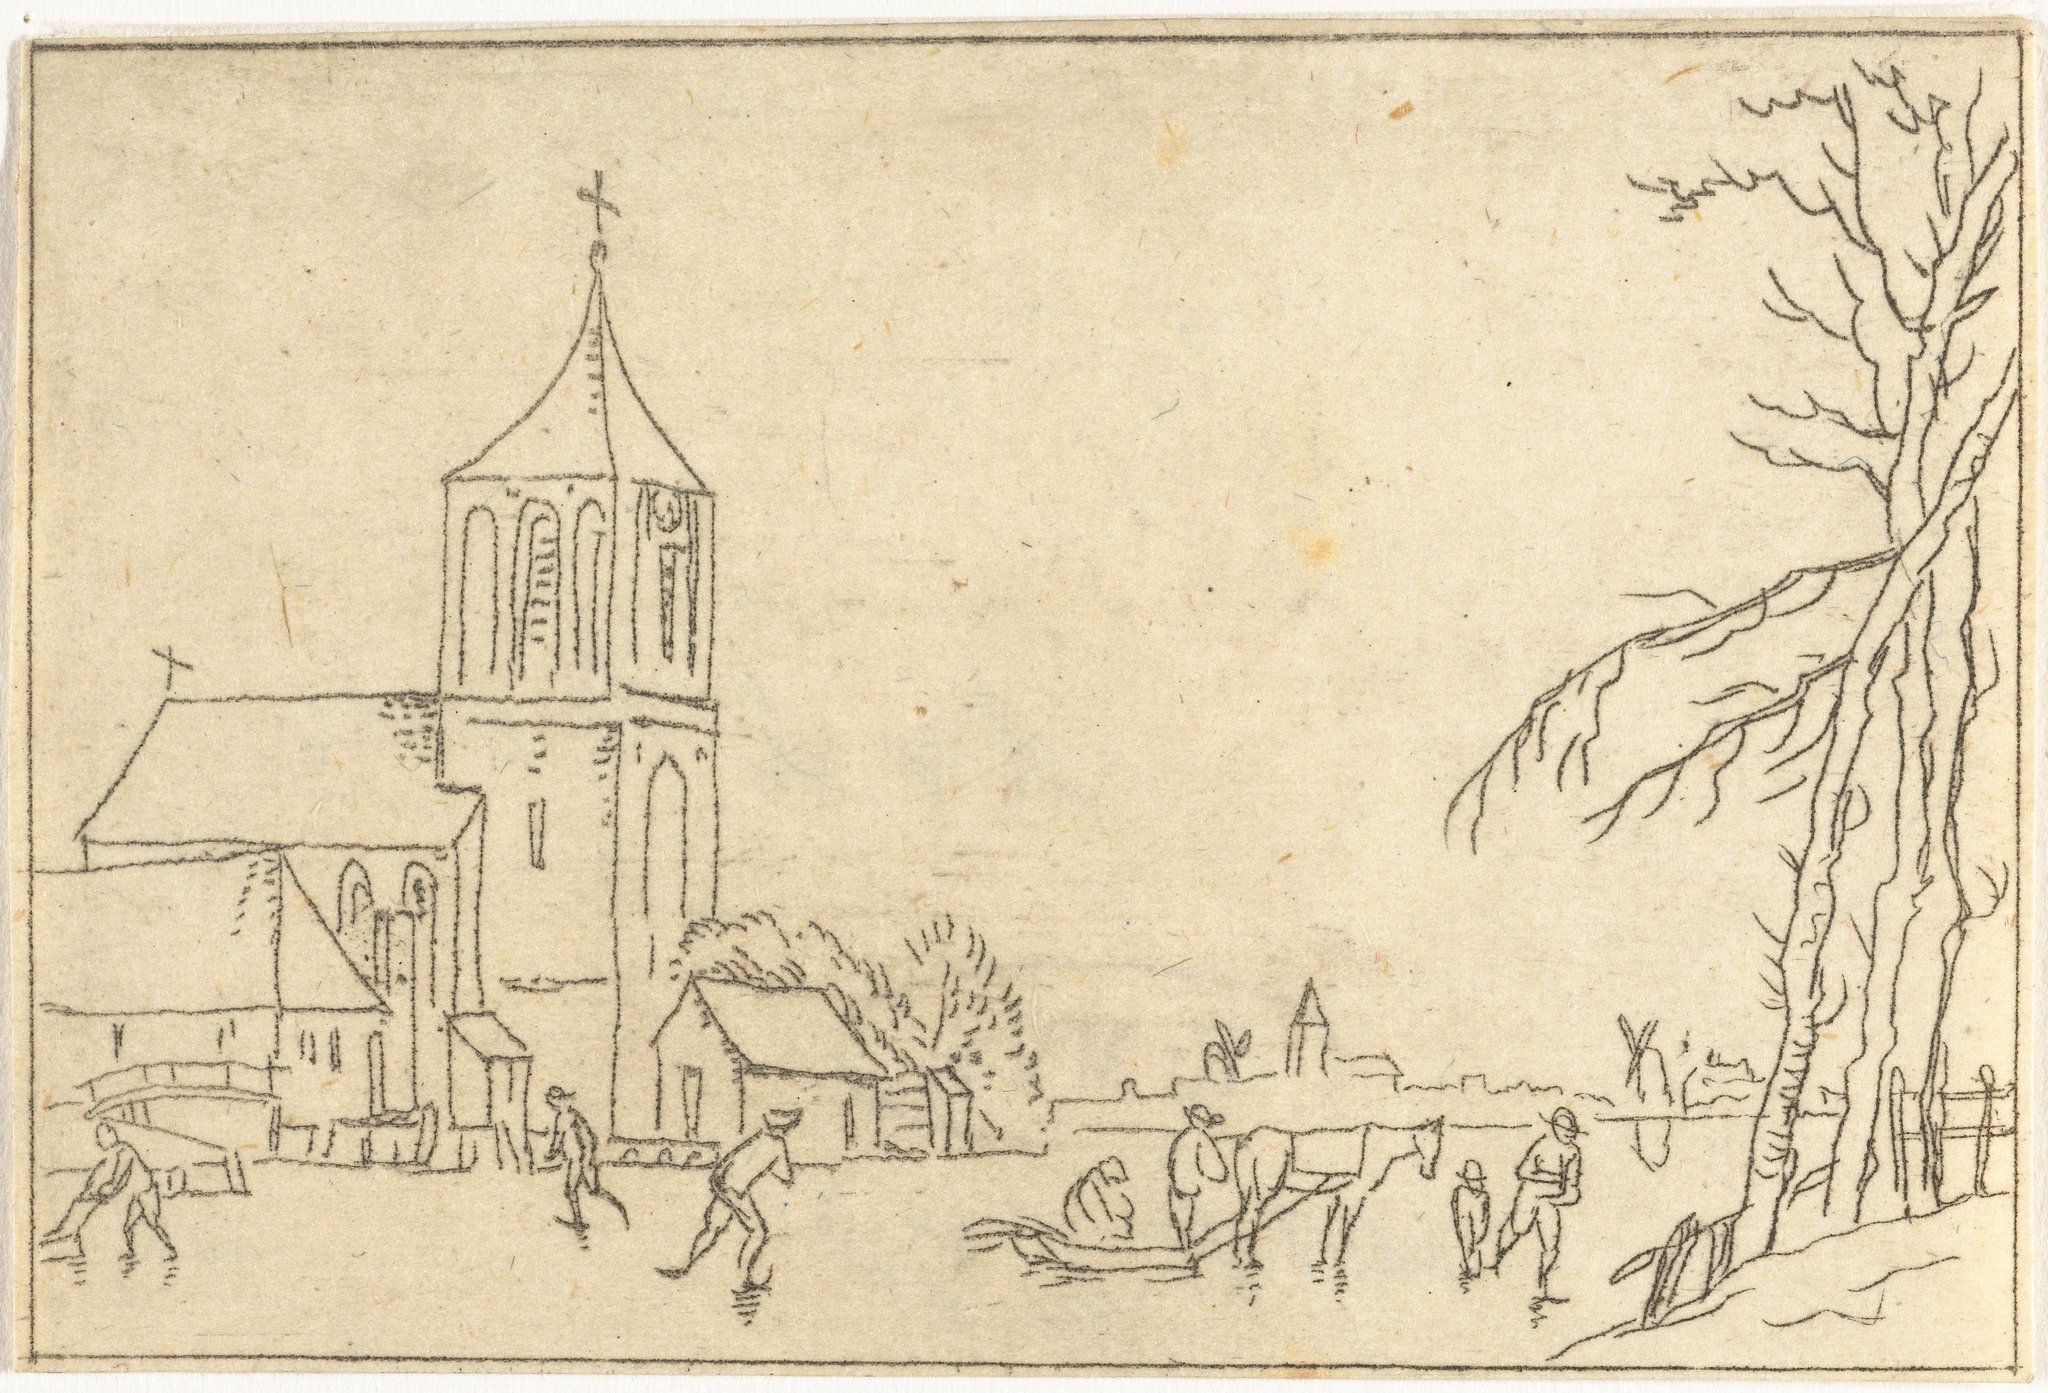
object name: print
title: Wintergezicht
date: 1778-1838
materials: paper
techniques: etching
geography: netherlands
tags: ice ~ freezing weather, skates (winter sports) (+ out of doors (sports, games, etc.))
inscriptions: collector's mark: Lugt 2228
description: Schaatsers op het ijs, op de achtergrond een kerk met huizen.